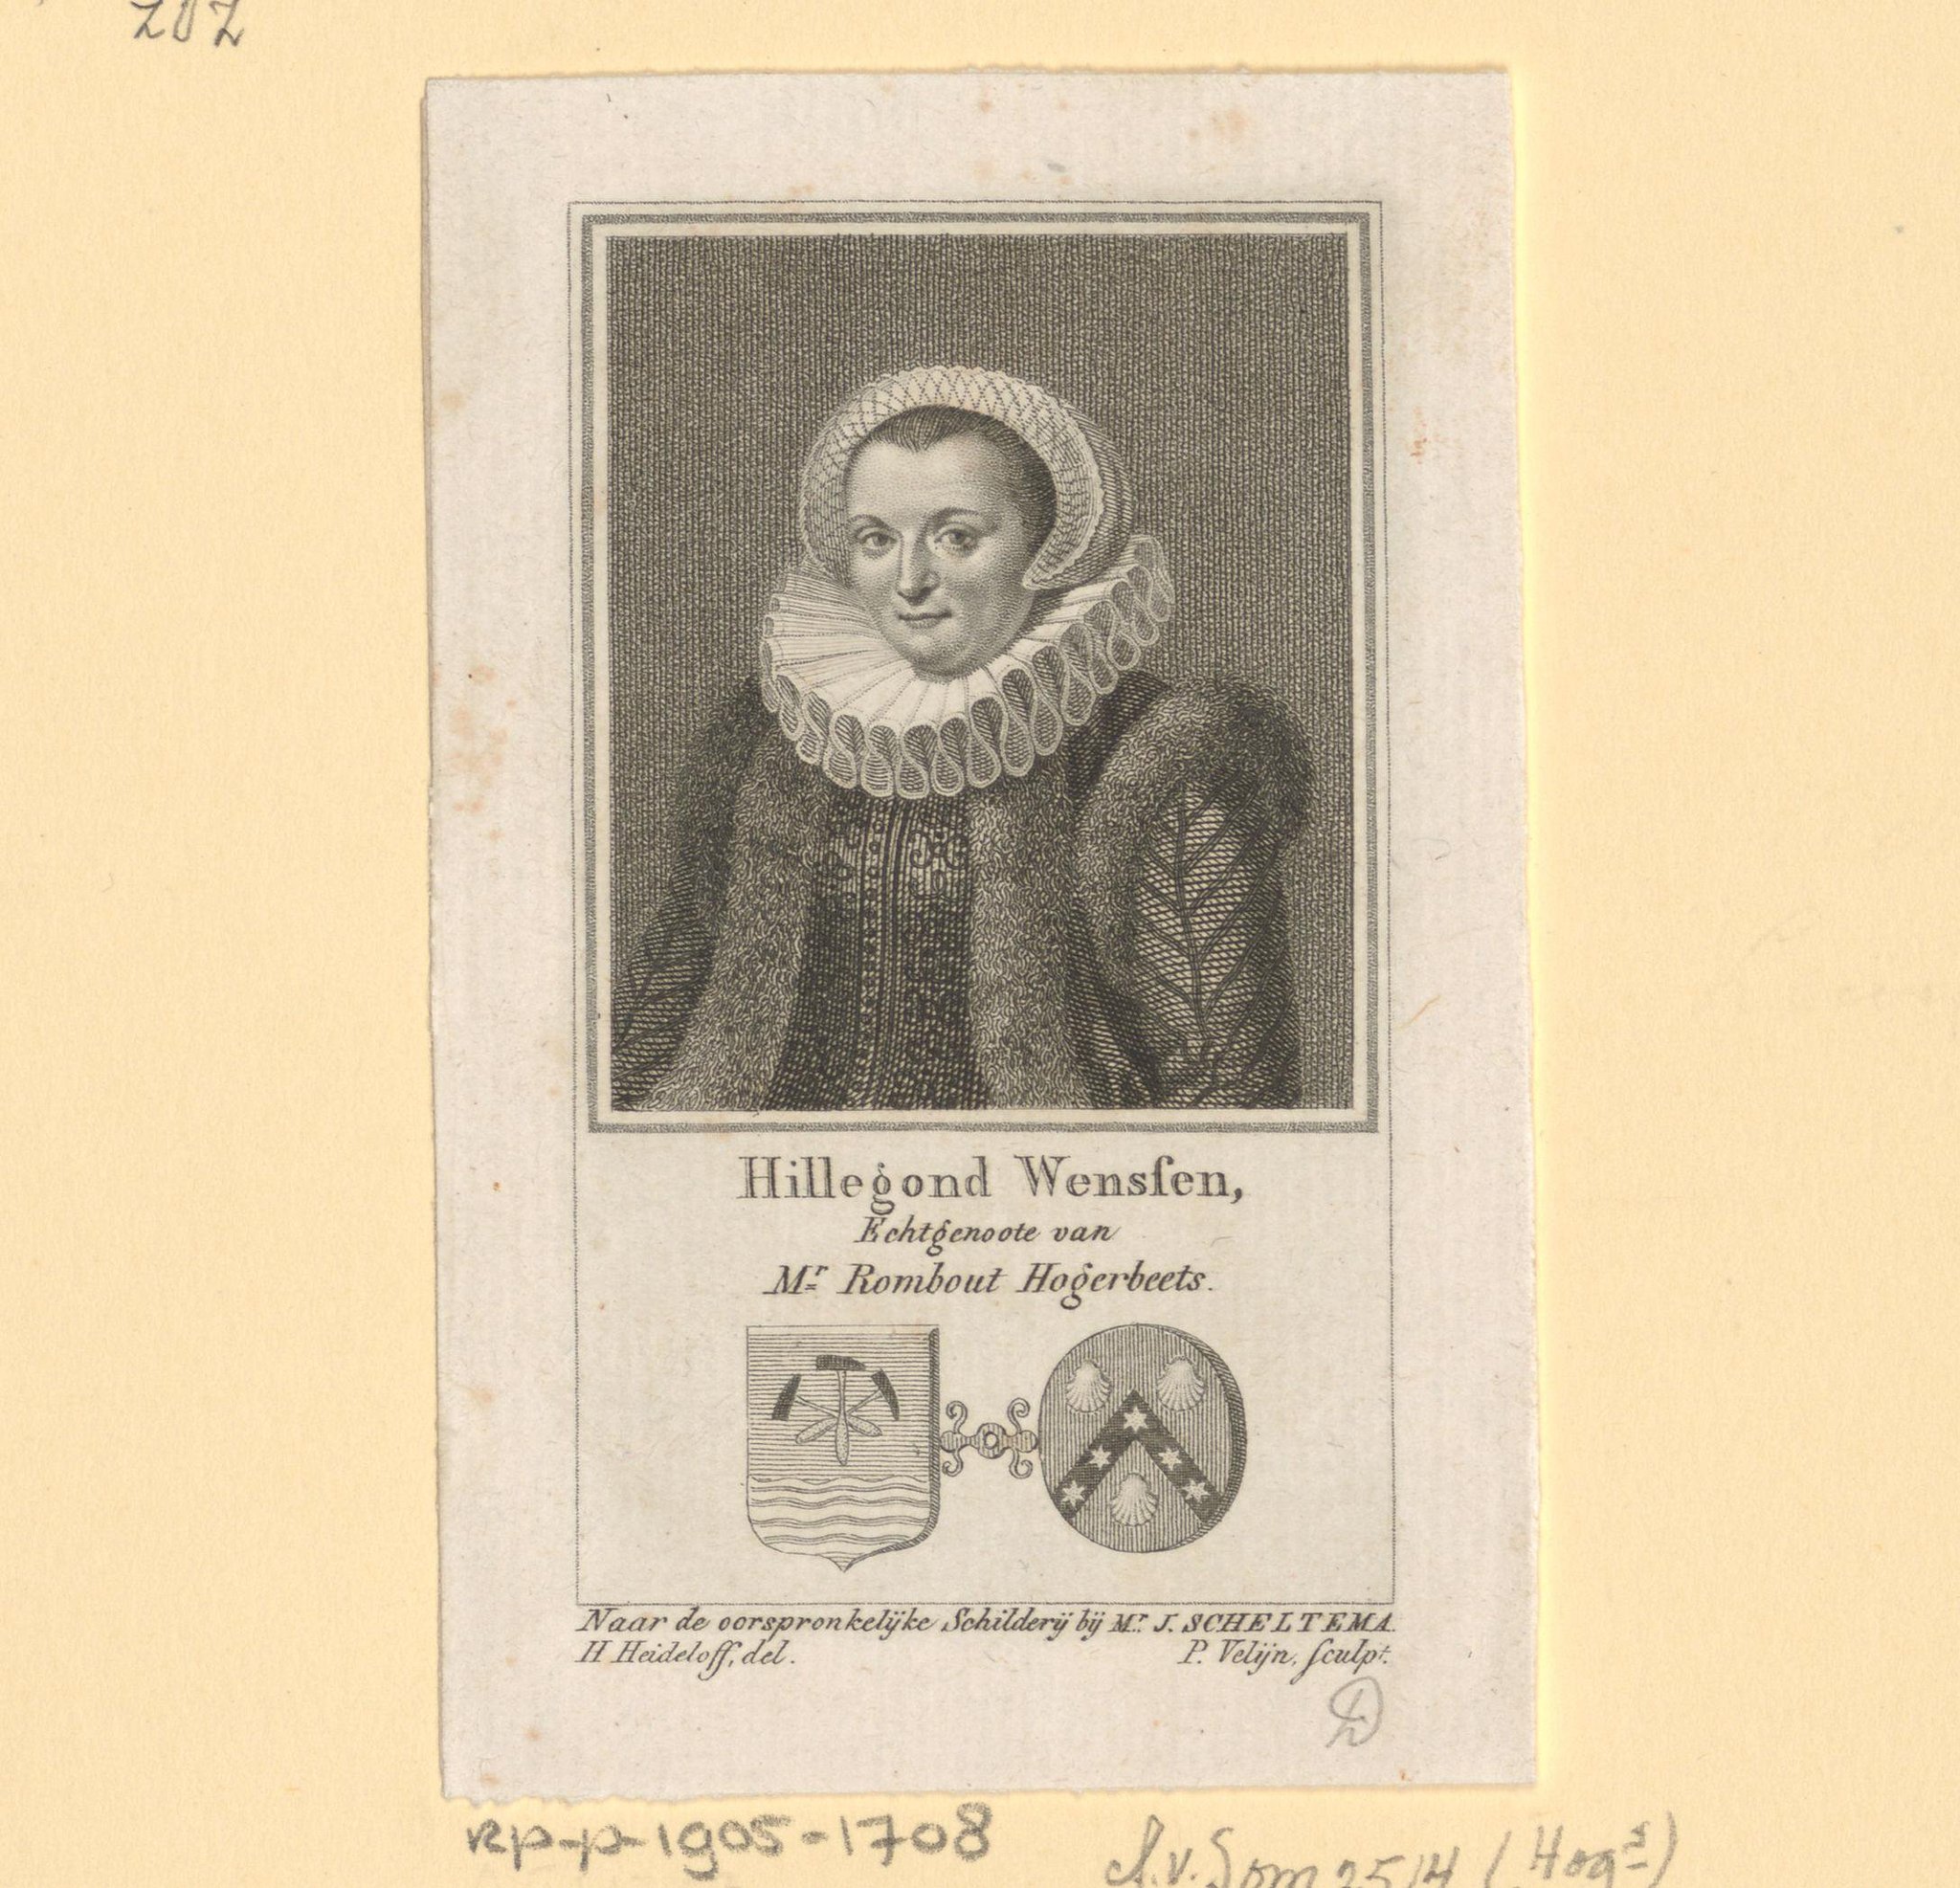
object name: print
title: Portret van Hillegonda Wentzen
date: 1820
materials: paper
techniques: etching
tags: dordrecht, loevestein castle, historical persons - bb - woman, armorial bearing, heraldry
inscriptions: collector's mark: Lugt 2228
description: Prent waarschijnlijk uit: Lektuur voor vrouwen in den beschaafden stand. Den Haag: weduwe J. Allart en Comp., 1820.